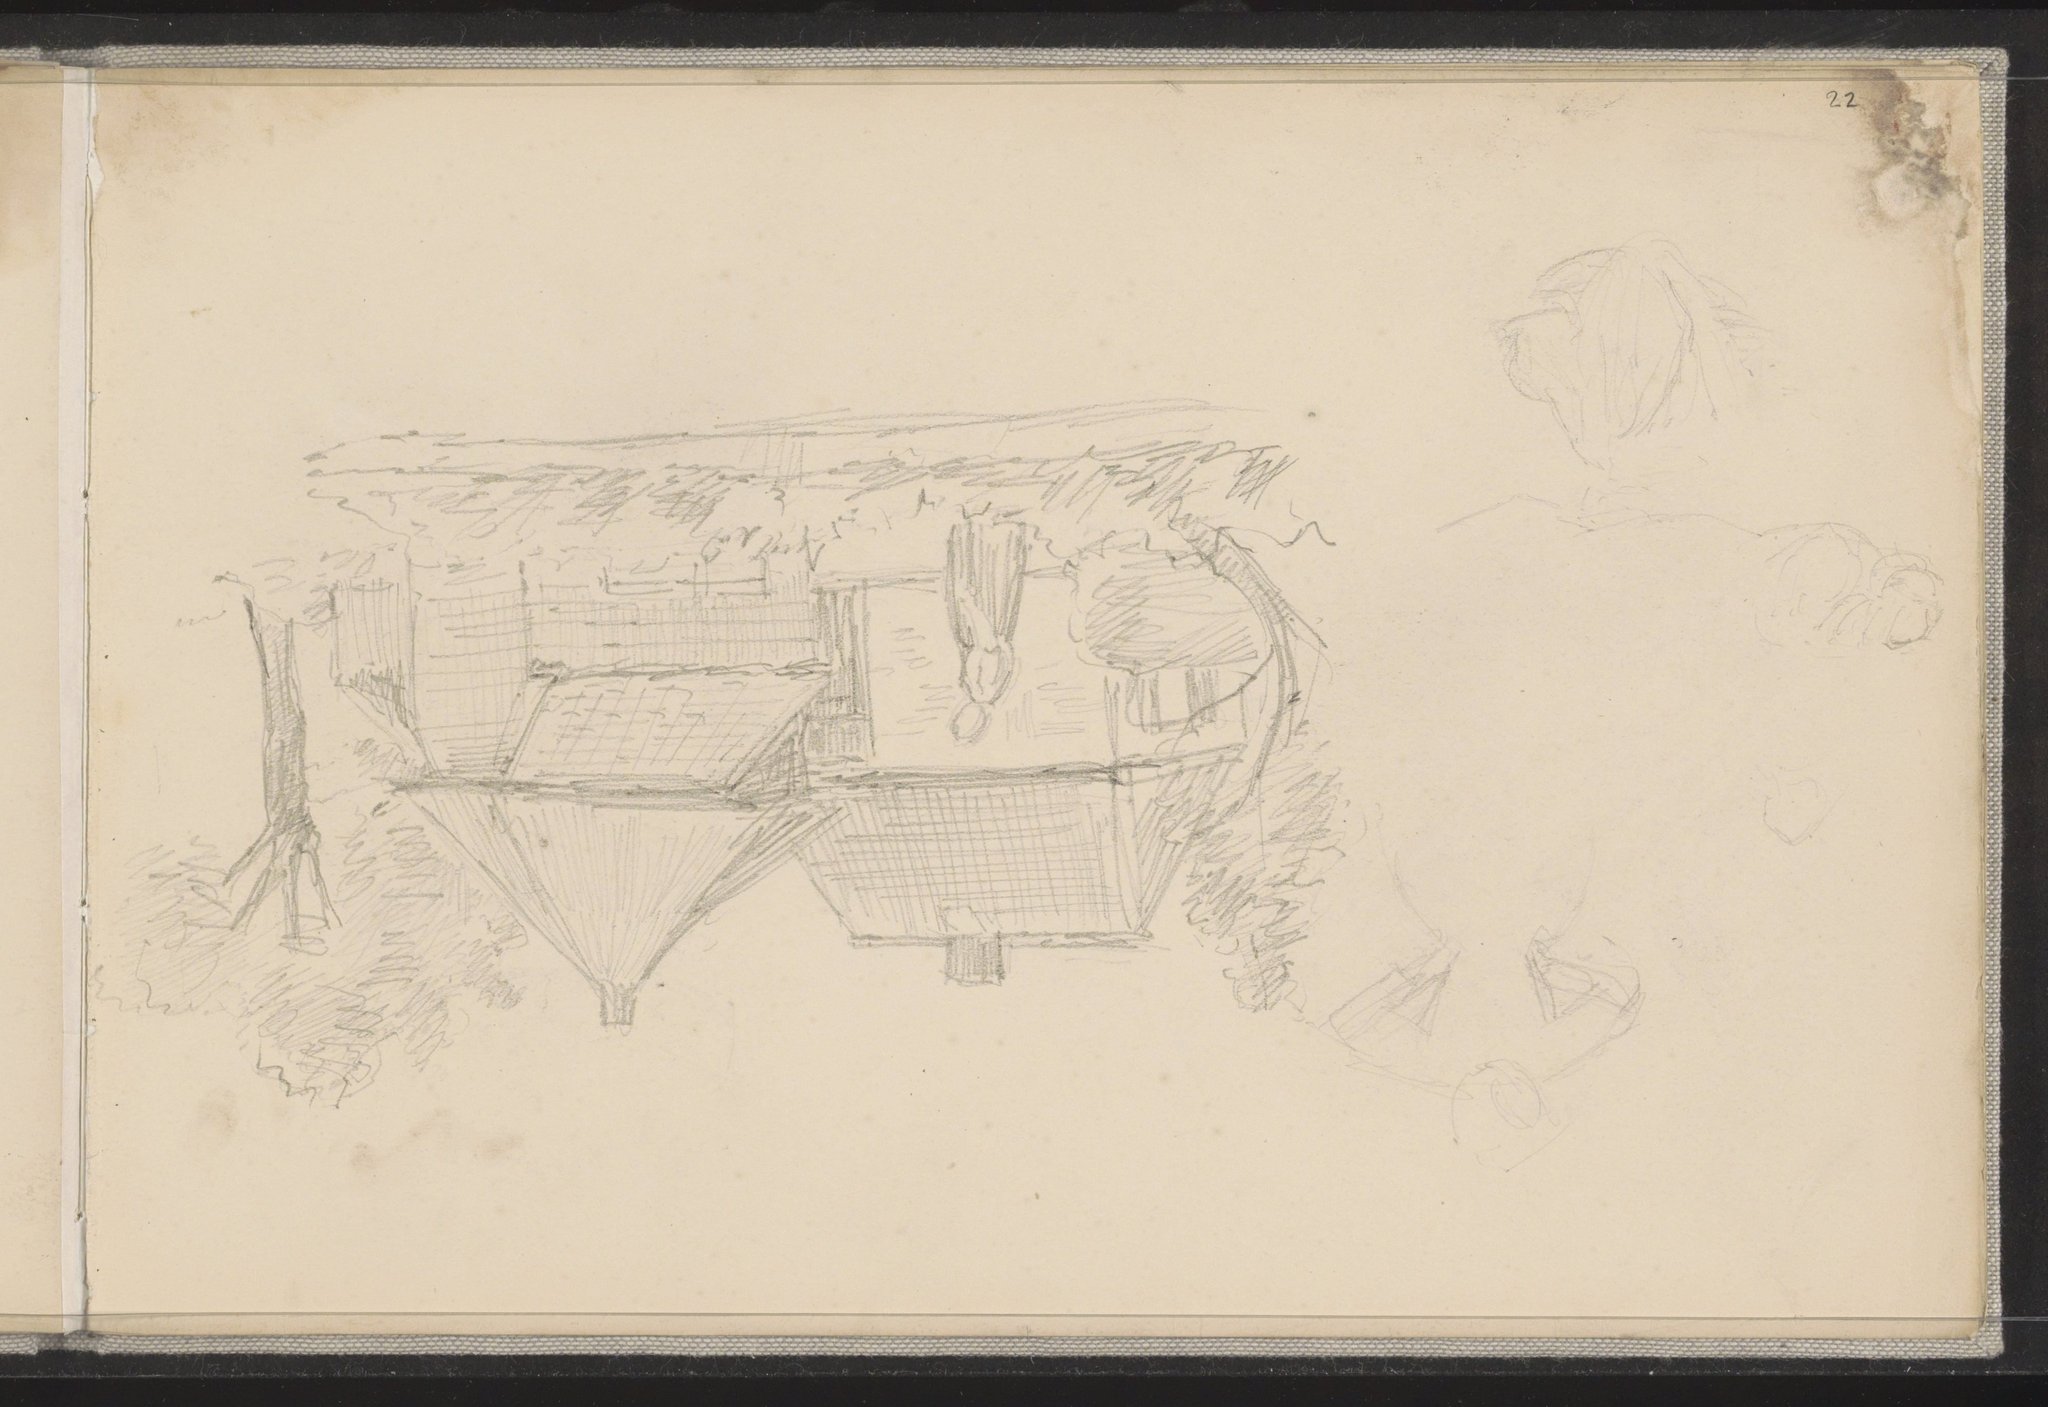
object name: sketchbook leaf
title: Vrouw in de tuin van een plattelandswoning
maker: jozef israëls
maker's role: draughtsman, painter, print maker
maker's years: 1824-1911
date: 1834-1911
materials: paper, pencil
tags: barn, cottage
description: Tevens figuurstudies. Blad 22 recto uit een schetsboek met 30 bladen.